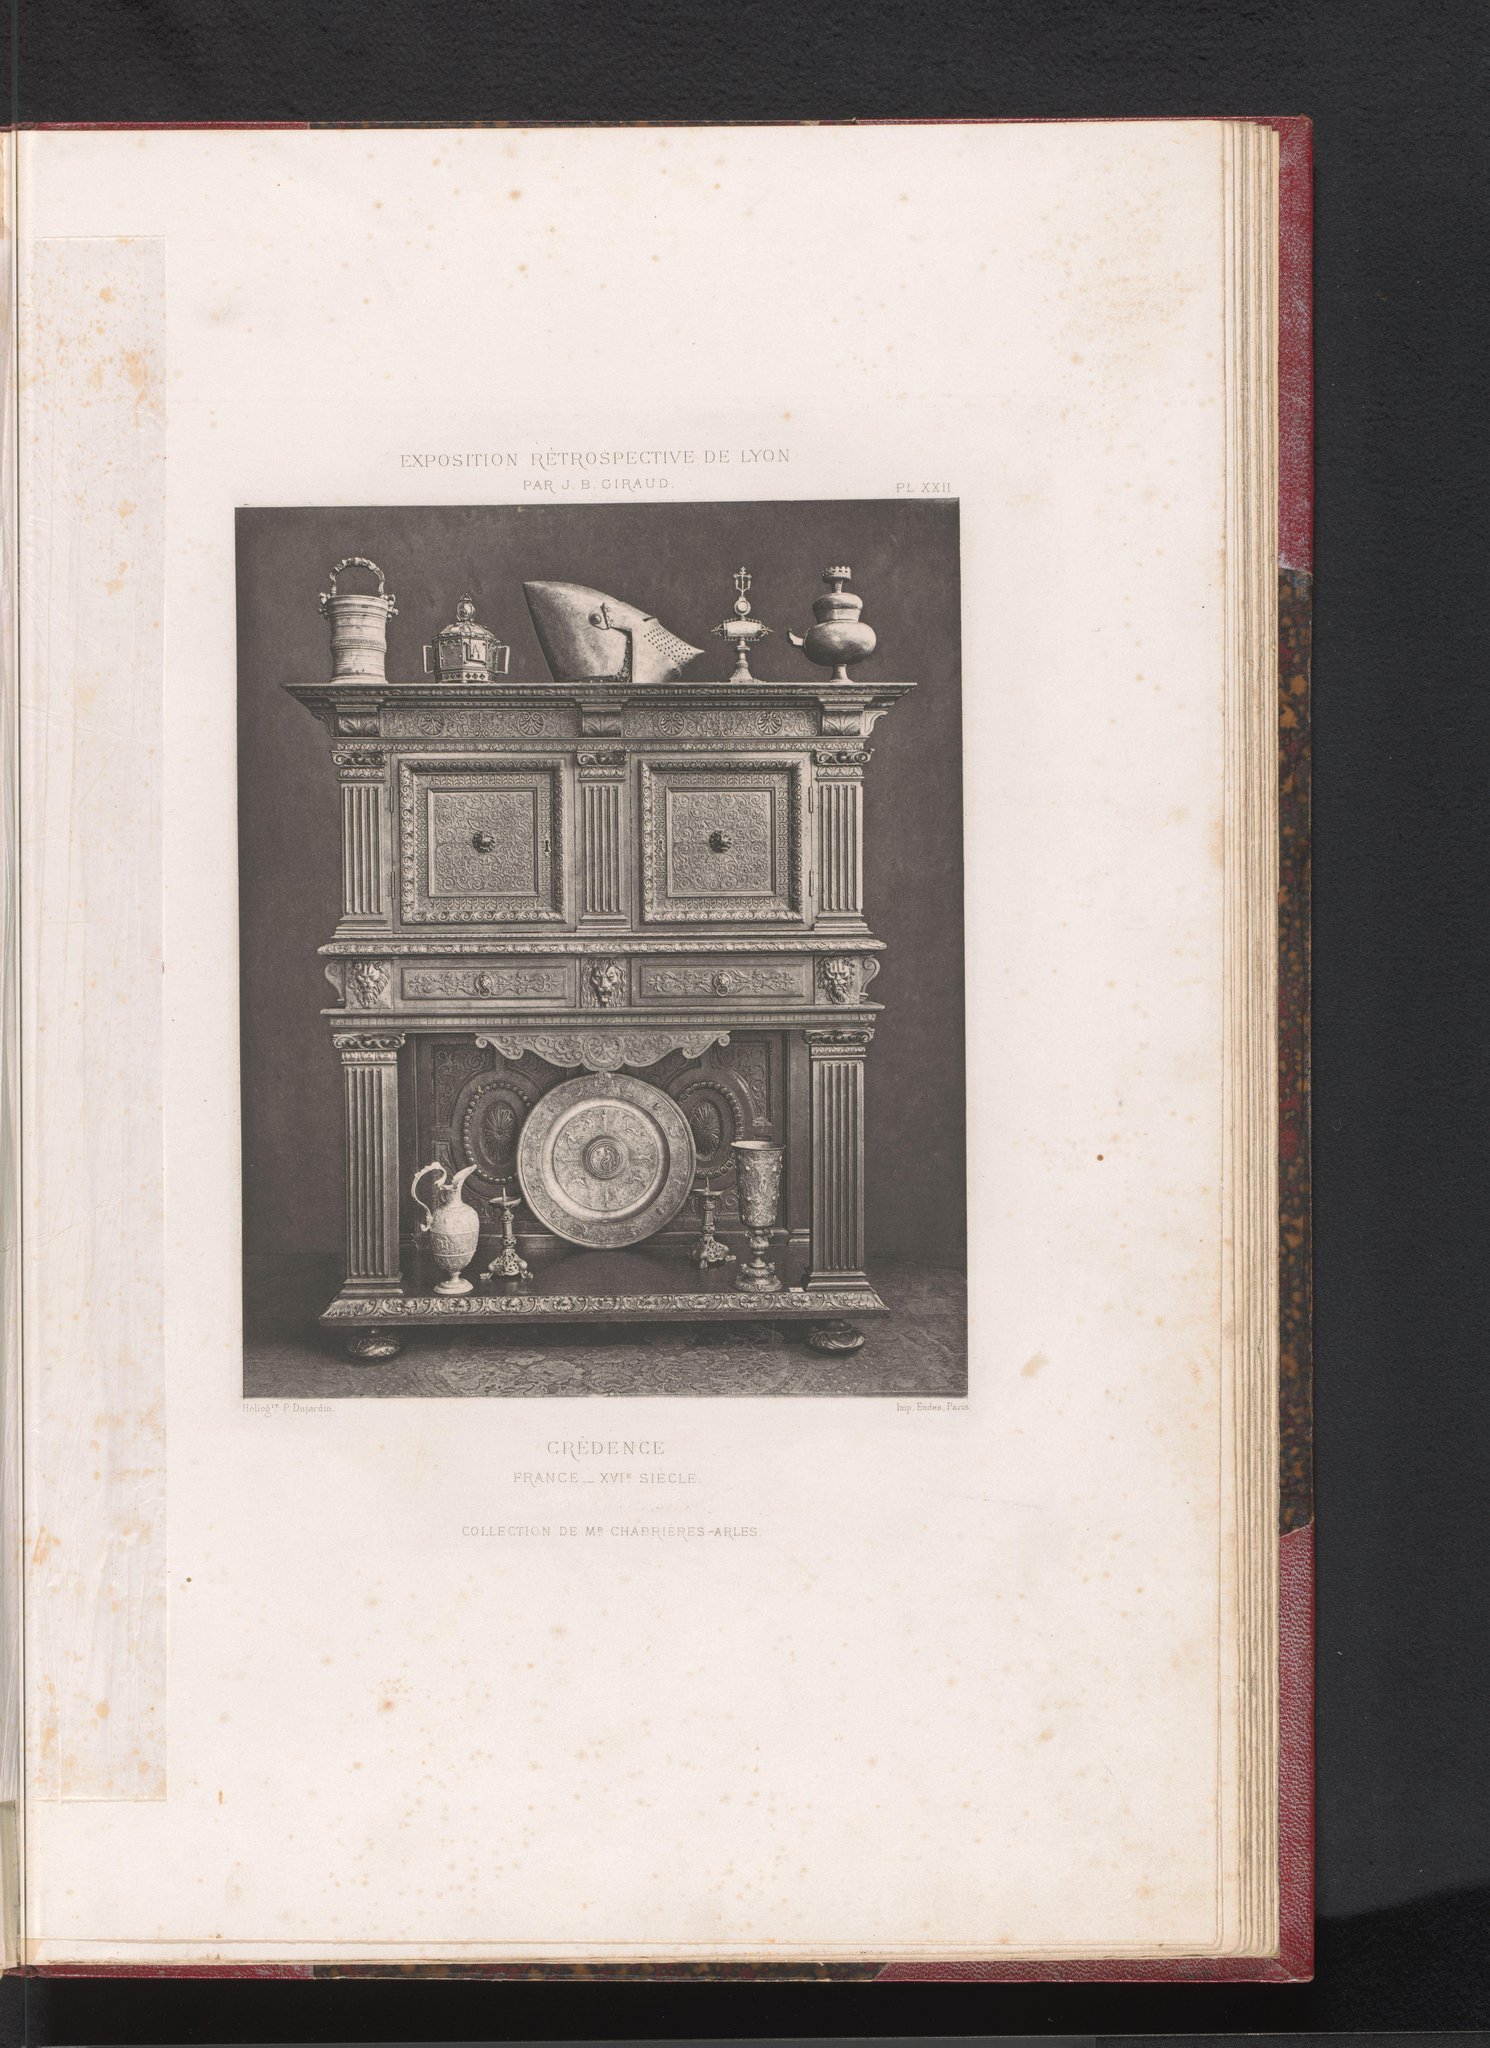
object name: page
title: 16de-eeuws Frans dressoir van hout, op de Exposition Rétrospective van 1877 in Lyon, Frankrijk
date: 1877-1880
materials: paper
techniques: photoaquatint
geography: lyon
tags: ornamental cupboard (+ wood and other phytogenic material), lyon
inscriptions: inscription: ‘CRÉDENCE/ FRANCE_XVIe SIÈCLE/ COLLECTION DE Mr CHABRIÈRES-ARLÈS.’, inscription: ‘EXPOSITION RÉTROSPECTIVE DE LYON/ PAR J. B. GIRAUD.’, number: ‘PL. XXII.’